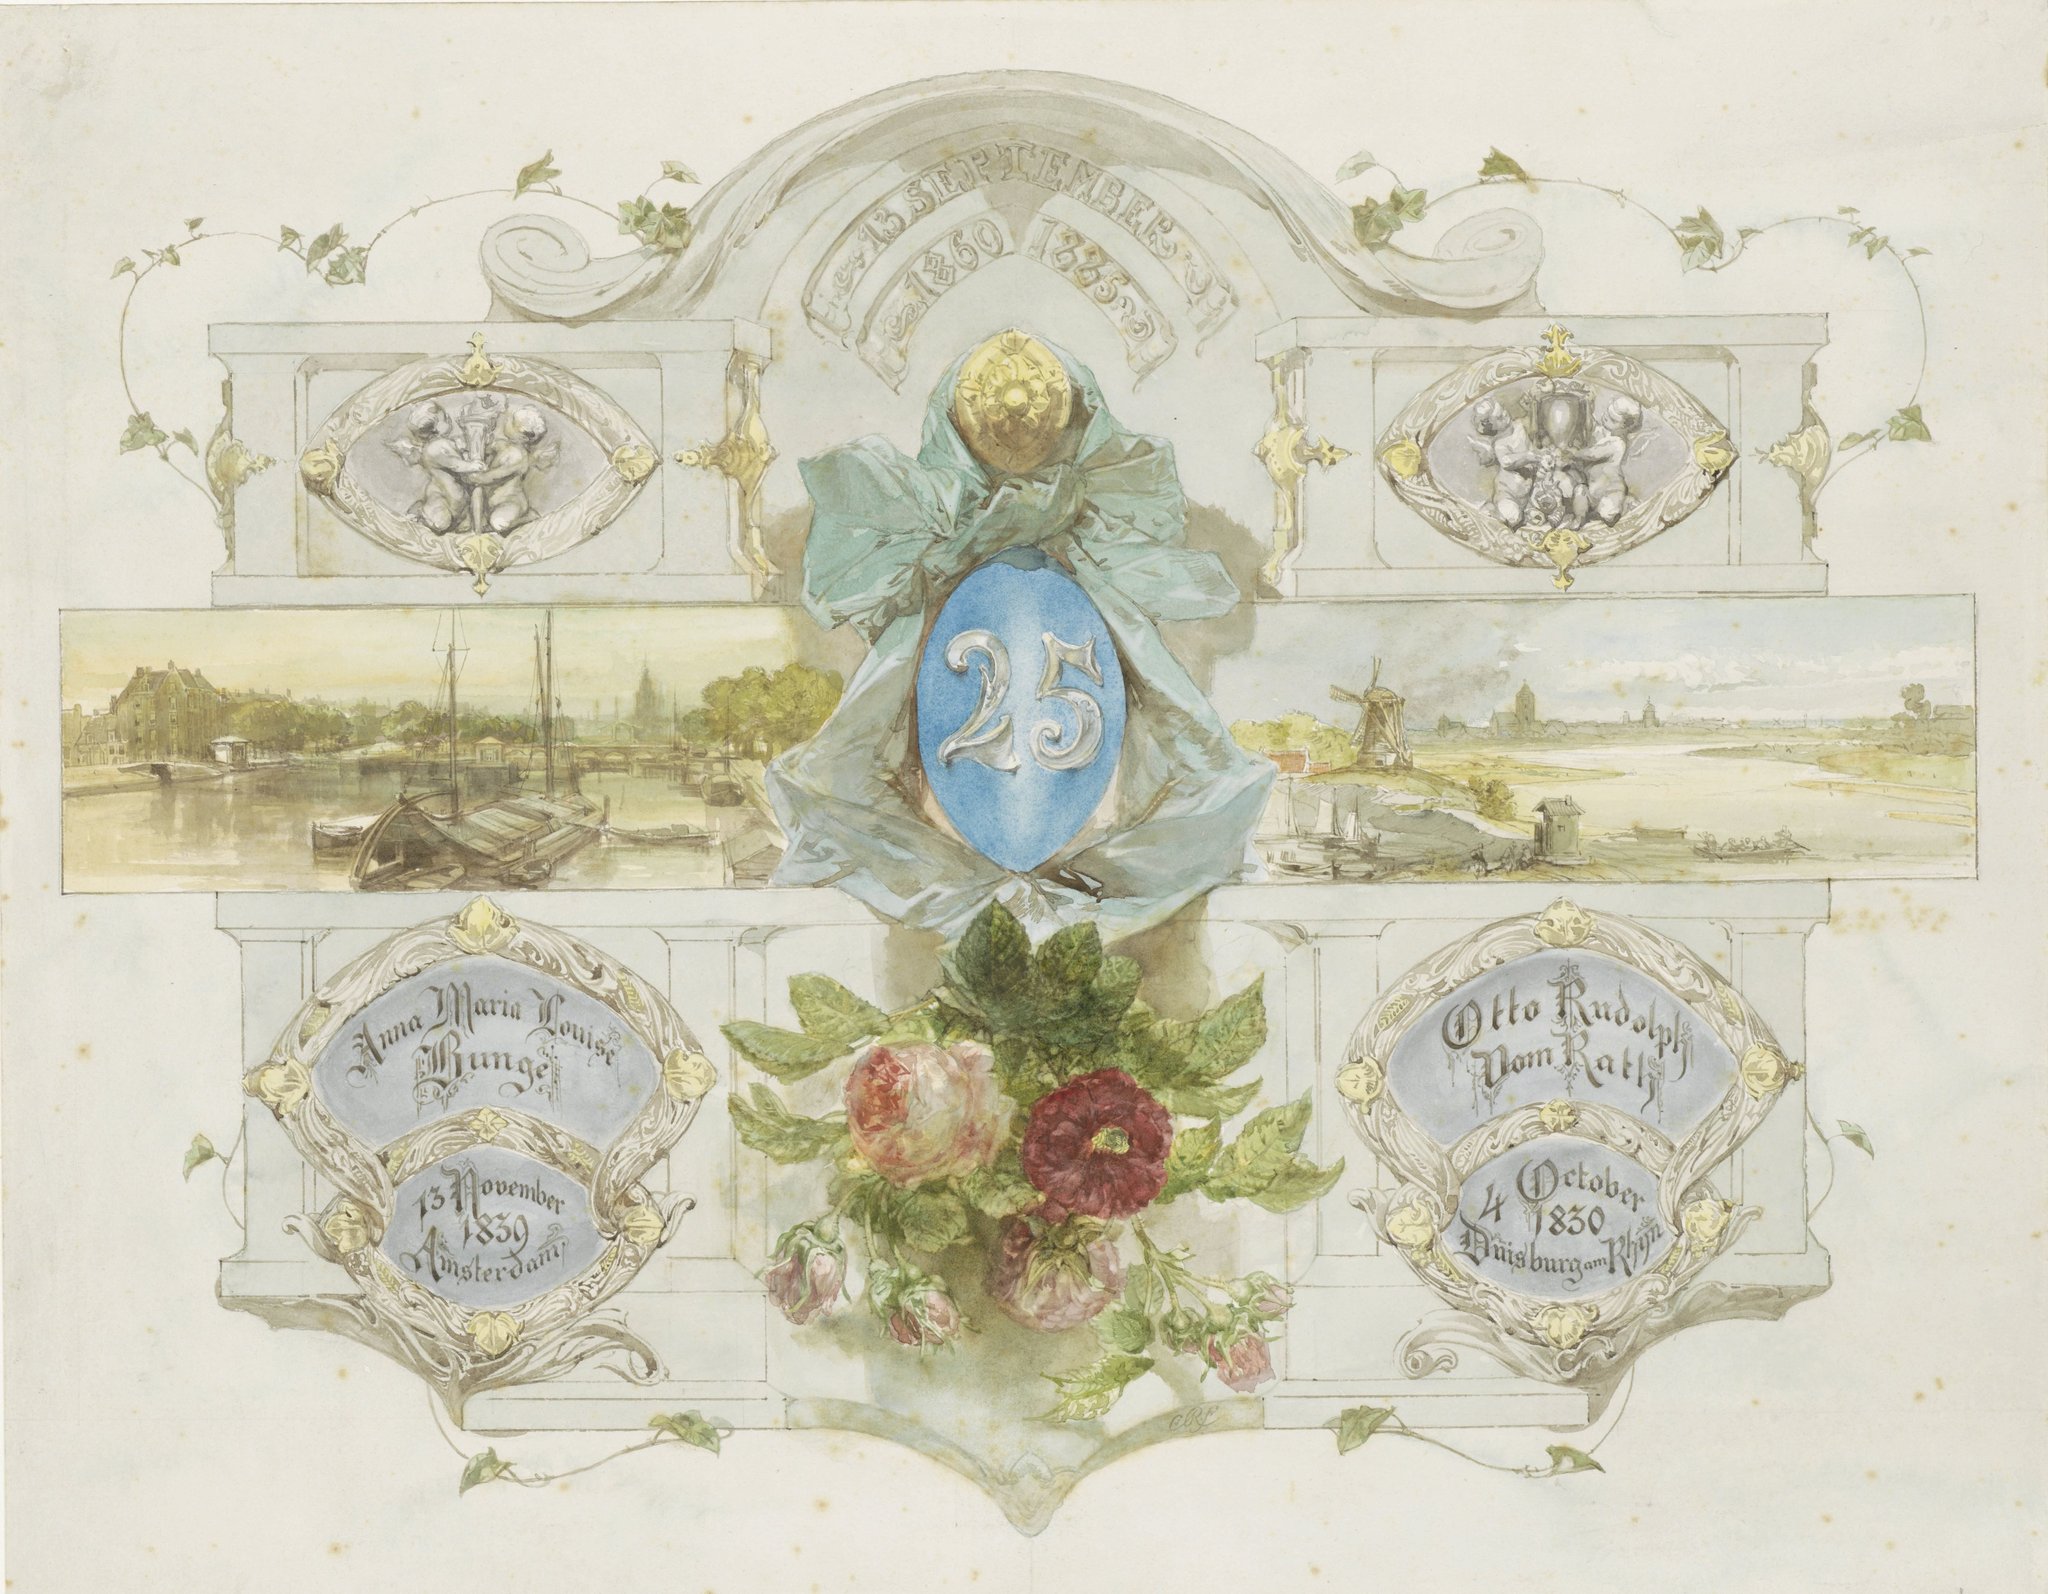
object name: watercolor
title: Felicitatie op de zilveren bruiloft van Otto Rudolph vom Rath en Anna Maria Louise Bunge, 1885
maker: charles rochussen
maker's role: draughtsman, painter, print maker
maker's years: 1814-1894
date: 1885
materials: ink, paper, watercolor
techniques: brush, pen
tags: silver anniversary, historical events and situations